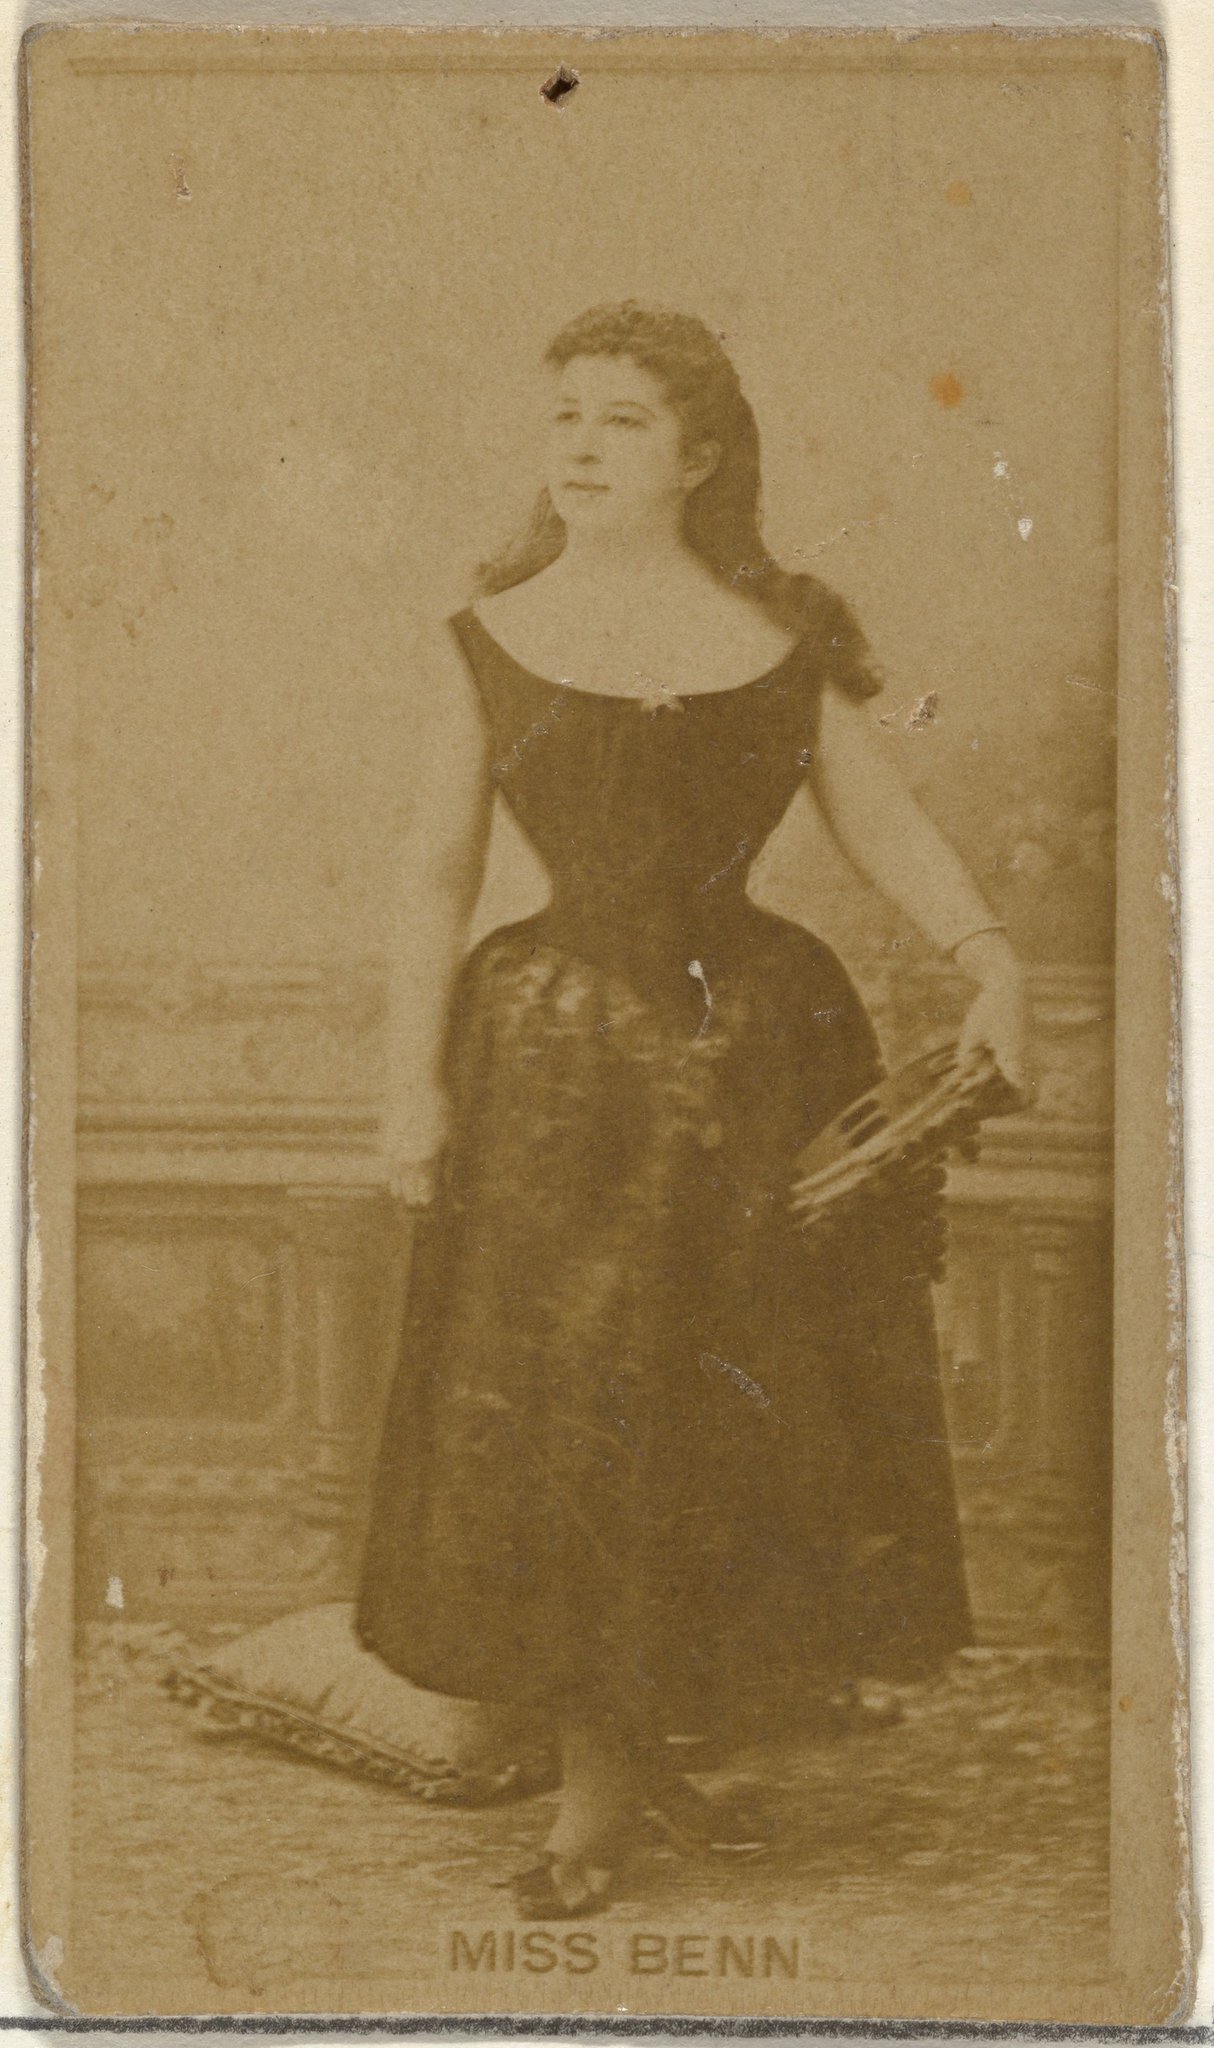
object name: photograph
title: Miss Benn, from the Actors and Actresses series (N145-8) issued by Duke Sons & Co. to promote Duke Cigarettes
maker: w. duke, sons & co.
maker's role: publisher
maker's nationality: american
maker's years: 1870-1920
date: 1891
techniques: albumen silver print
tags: portraits,women,actresses